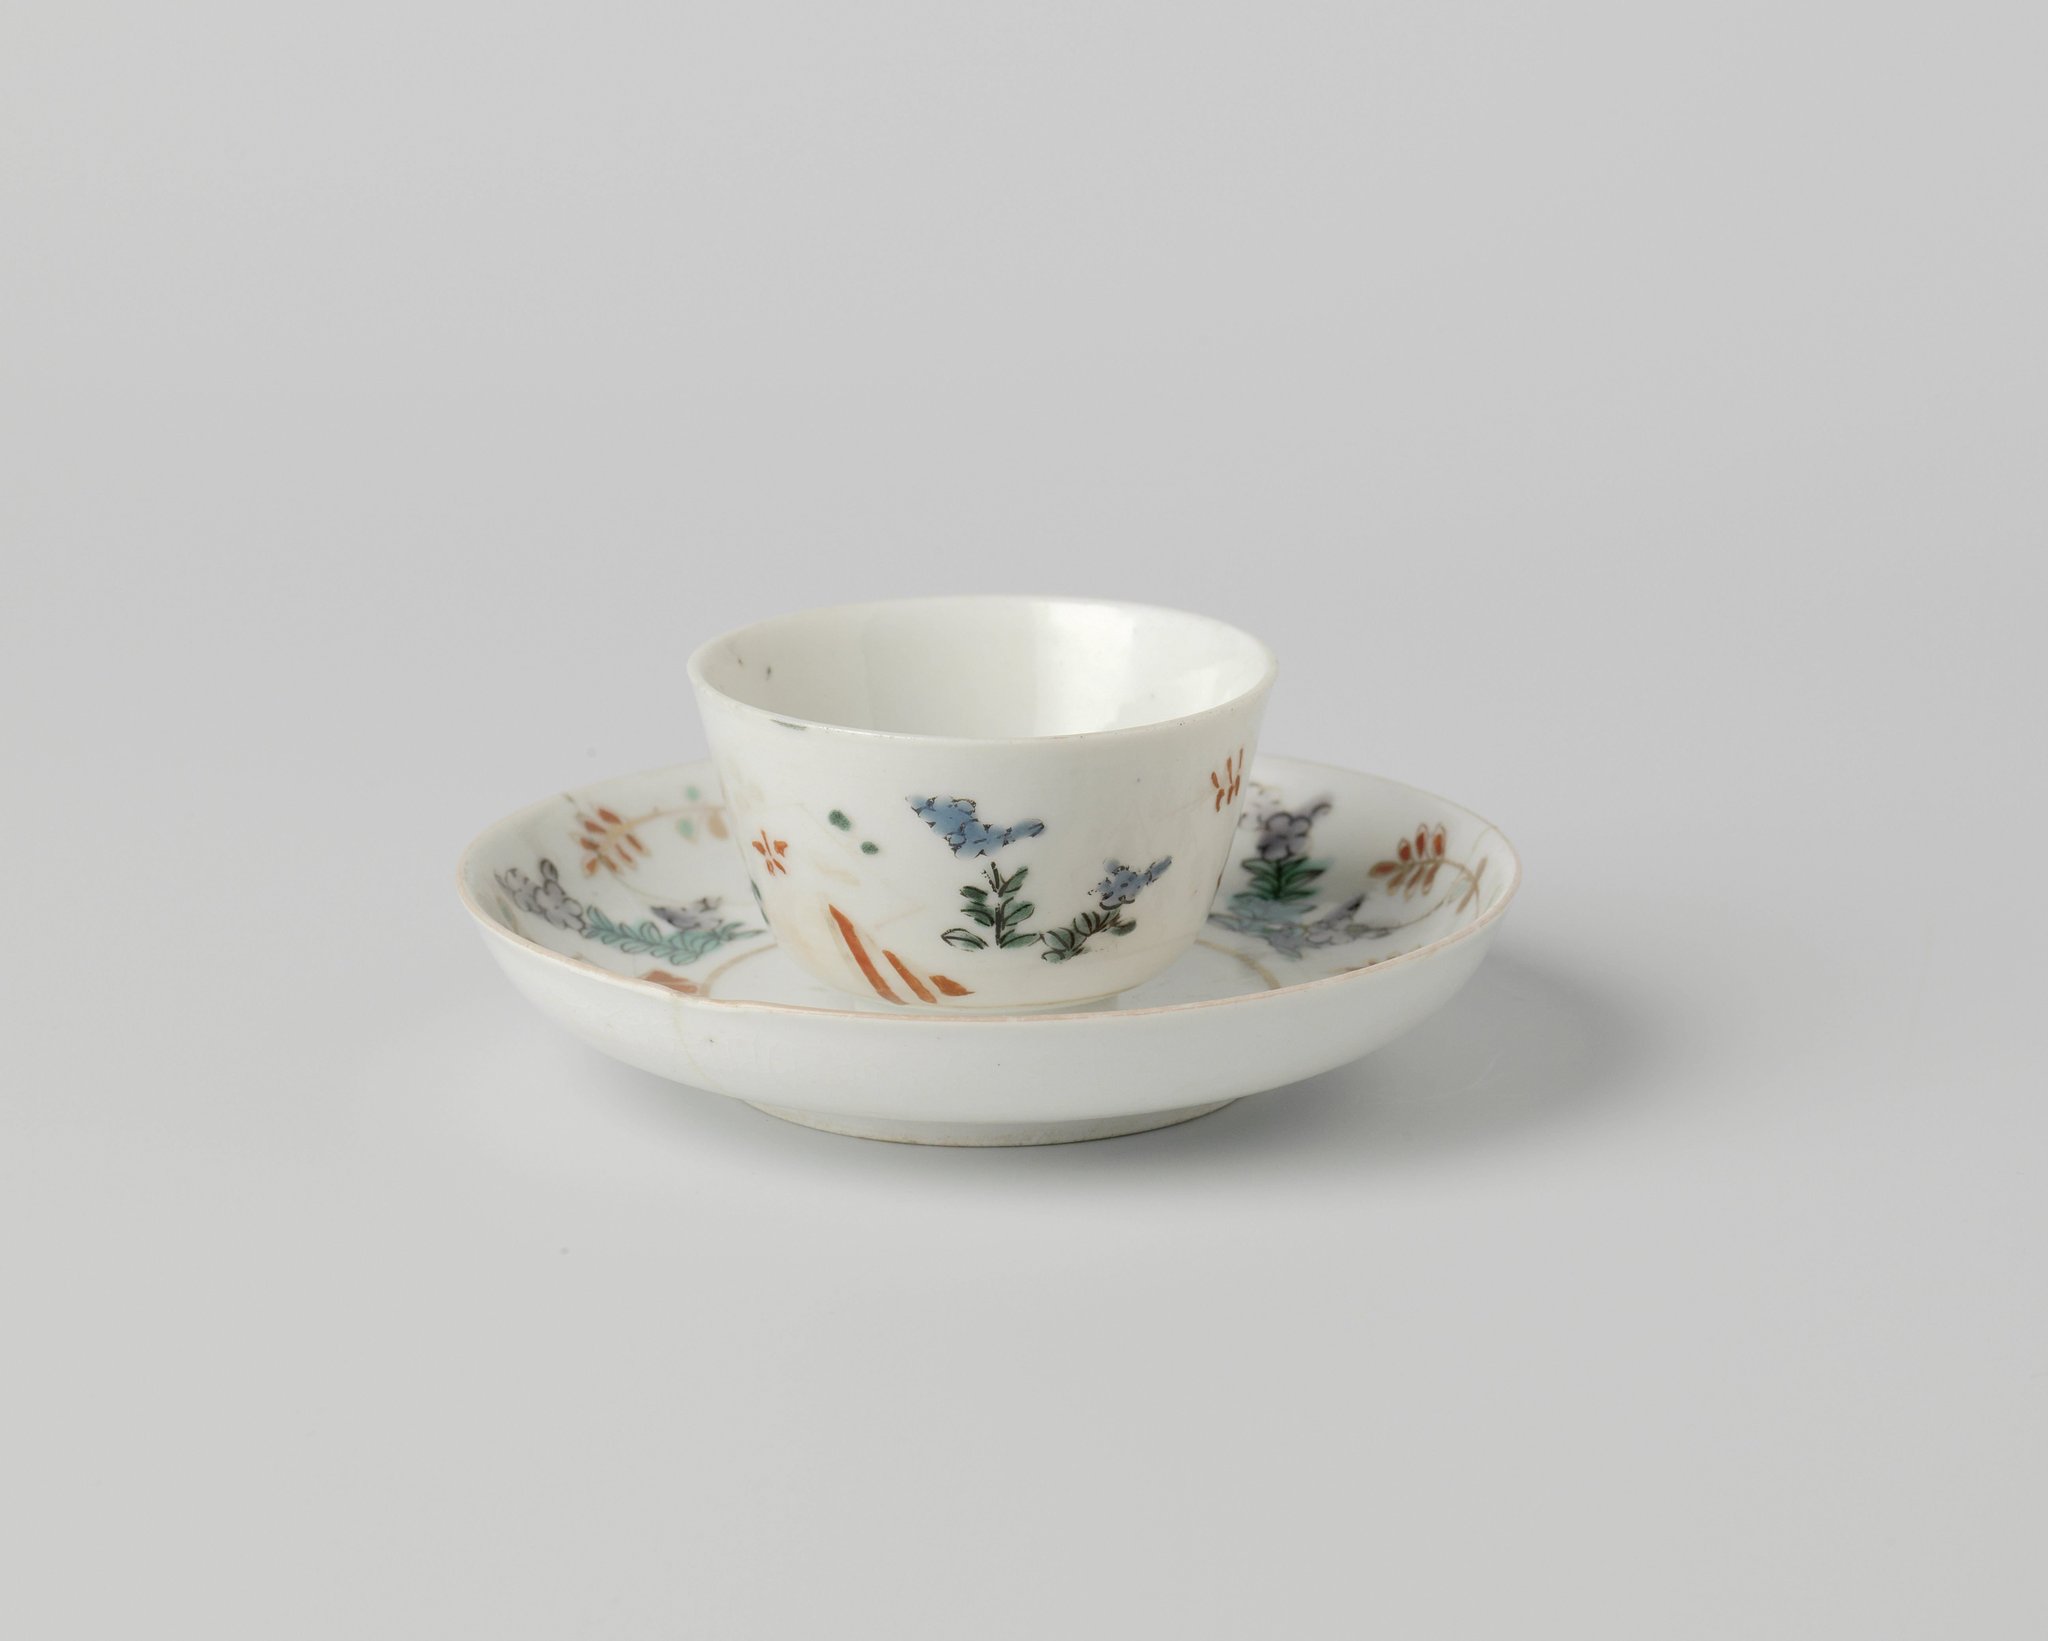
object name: kop en schotel, kop en schotel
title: Cup and saucer with lozenges and flowering plants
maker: Anonymous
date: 1800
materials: cobalt, glaze, gold, paint, porcelain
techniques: firing, gilding, turning, vitrification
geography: japan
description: Kop en schotel van porselein met iets uitlopende wand, beschilderd op het glazuur in blauw, rood, groen, aubergine, zwart en goud. Op het plat van de schotel een bloemtak in een medaillon; op het medaillon driemaal twee ruiten. Tussen de ruiten een bloeiende plant en een bloemtak. De kop met dezelfde decoratie. Gecraqueleerd glazuur. Schotel is gebroken geweest. Imari.